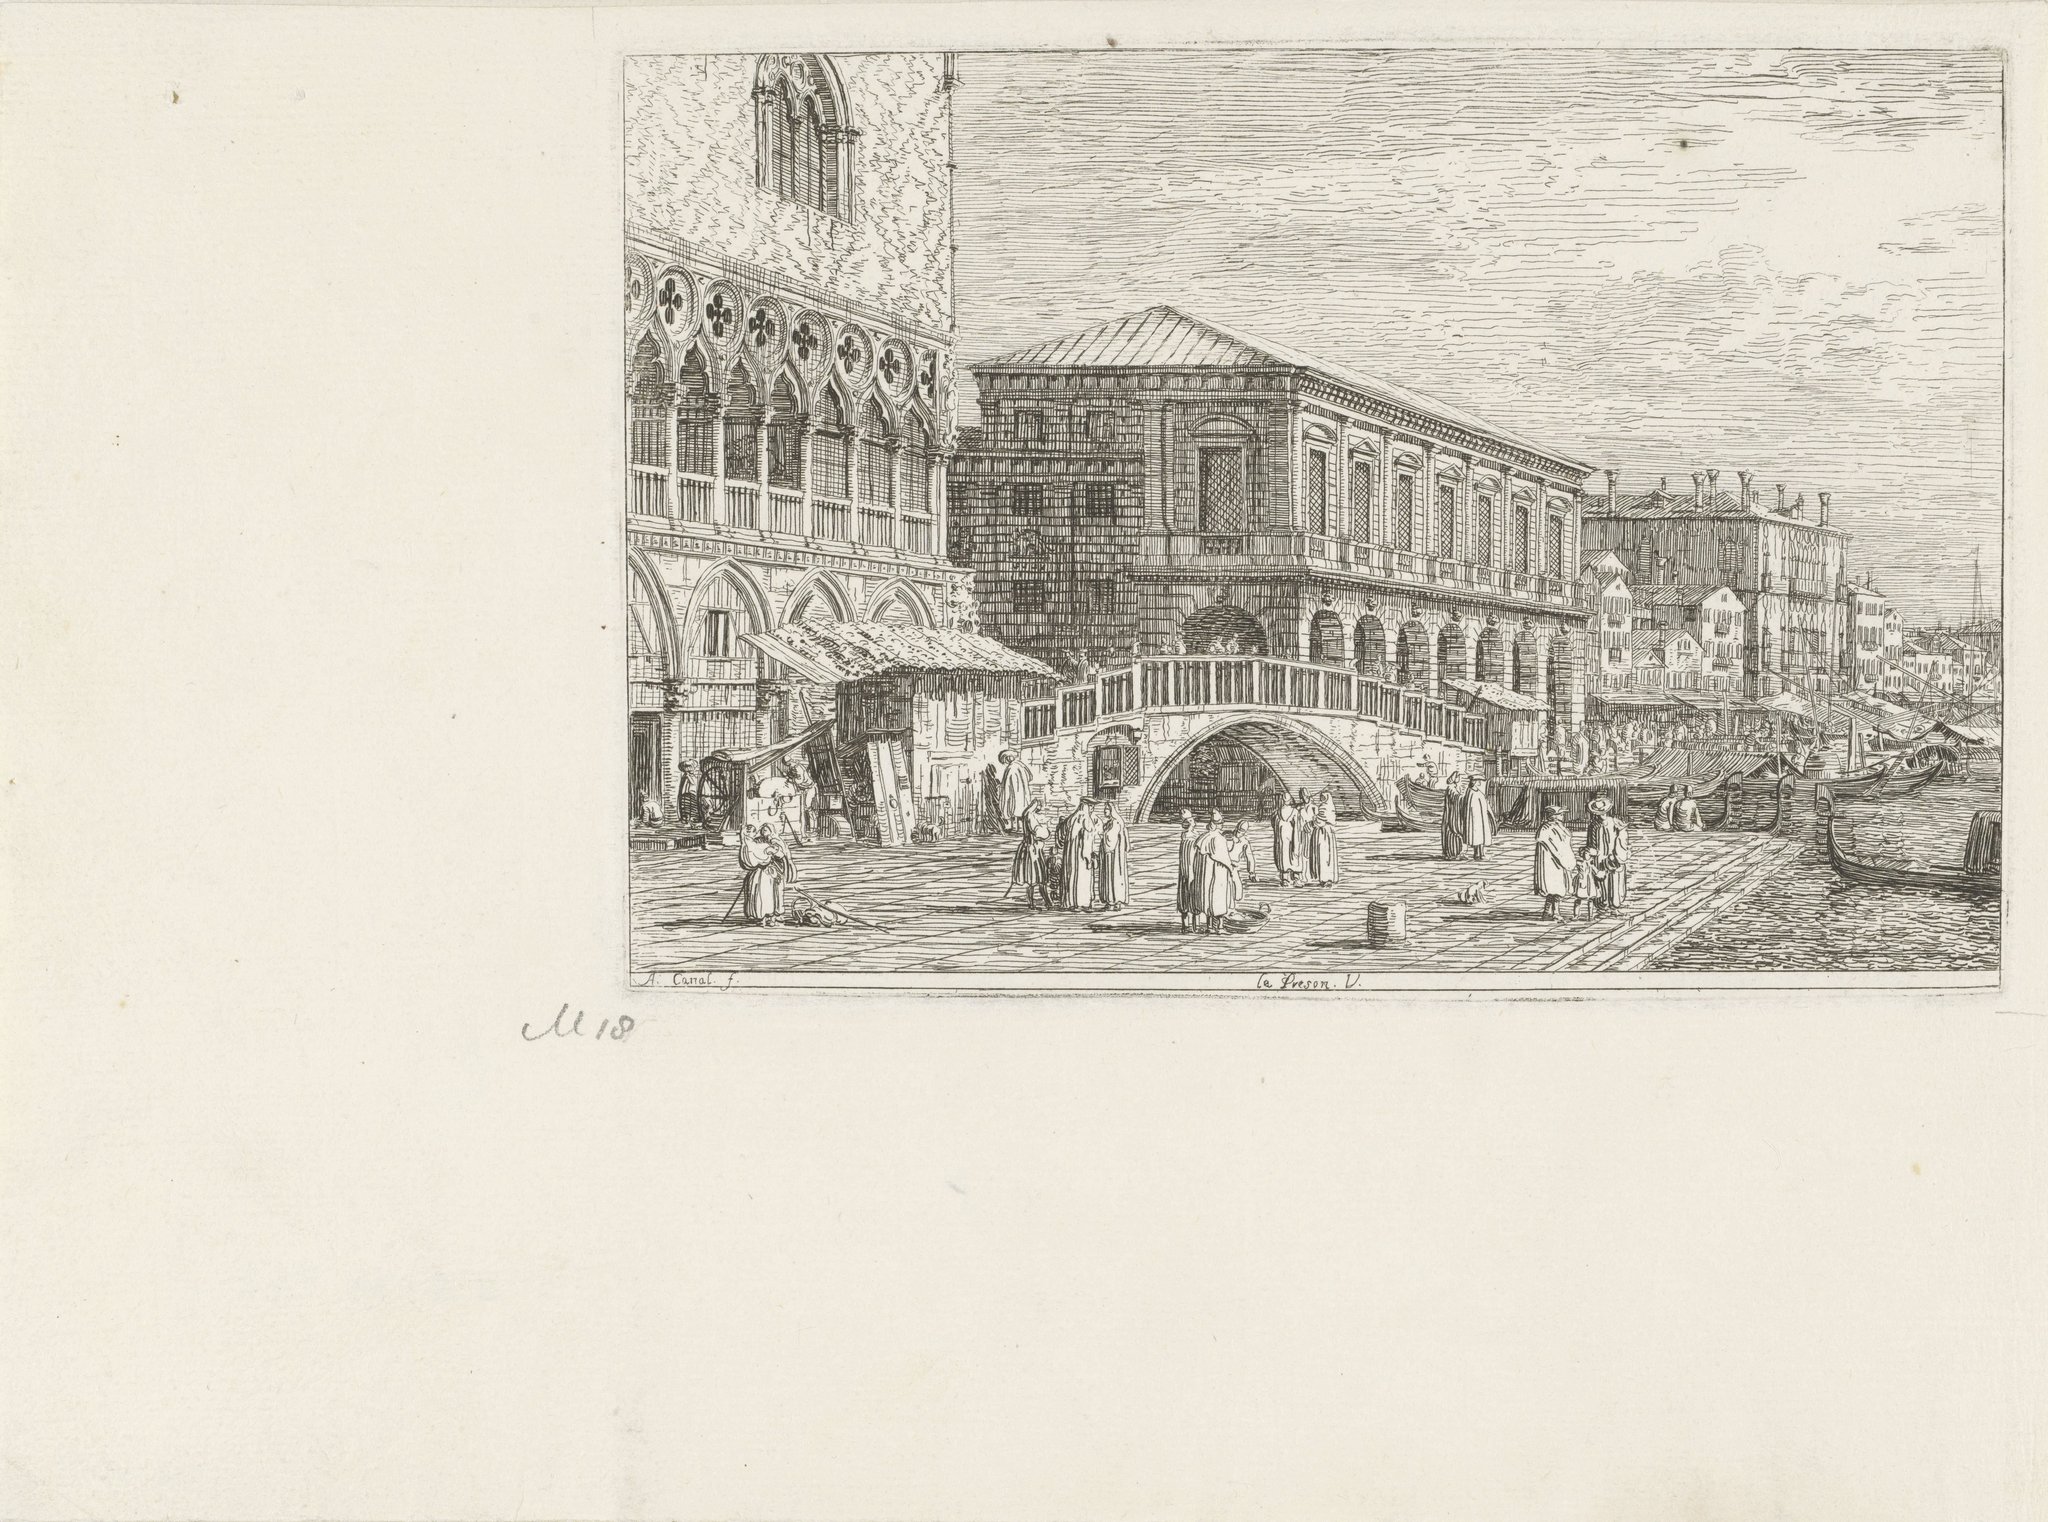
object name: print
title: Le preson V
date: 1707-1768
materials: paper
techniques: etching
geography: venice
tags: prison, jail, venice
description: Gezicht op het Dogepaleis en het Palazzo delle Prigione aan de Riva degli Schiavoni te Venetië. In het midden een brug over de Rio de Palazzo o de Canonica.